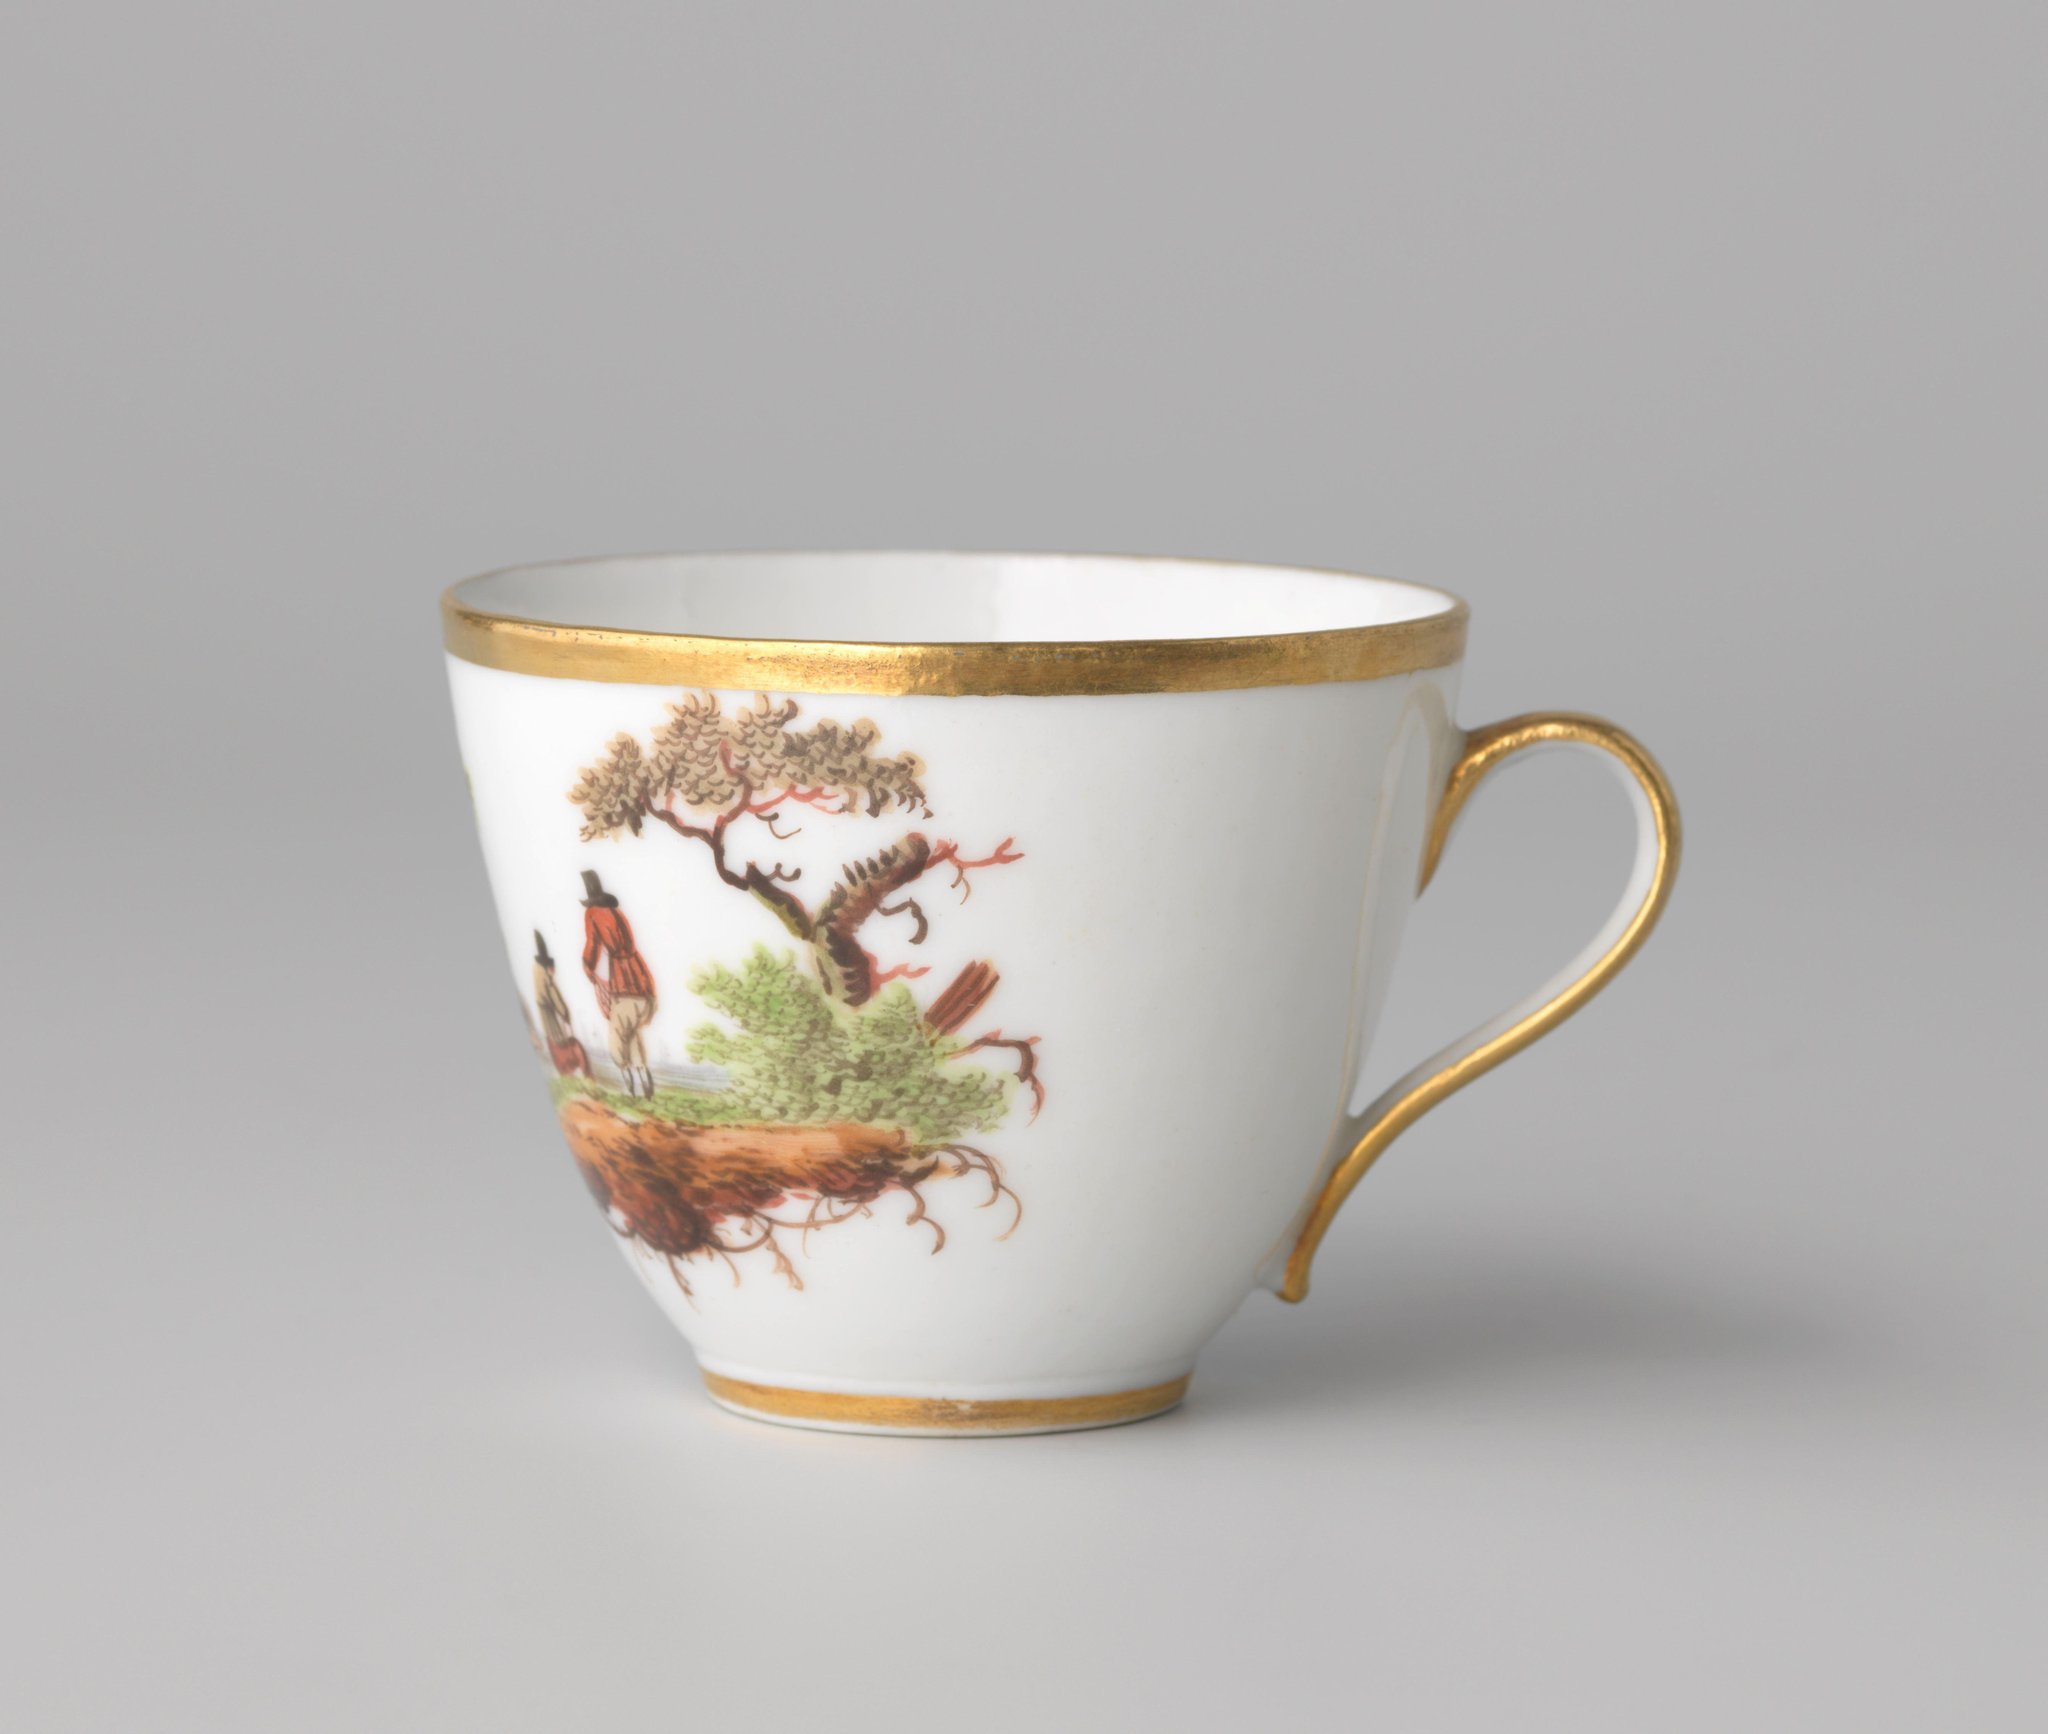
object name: cup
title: Kop en schotel met riviergezicht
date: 1809-1814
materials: porcelain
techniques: painted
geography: nieuwer-amstel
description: Kop versierd met een veelkleurig landschap. Een zitten de en staande man en een boerderij langs de rivier. Langs de randen en het oor een gouden rand. Gemerkt: Amstel.